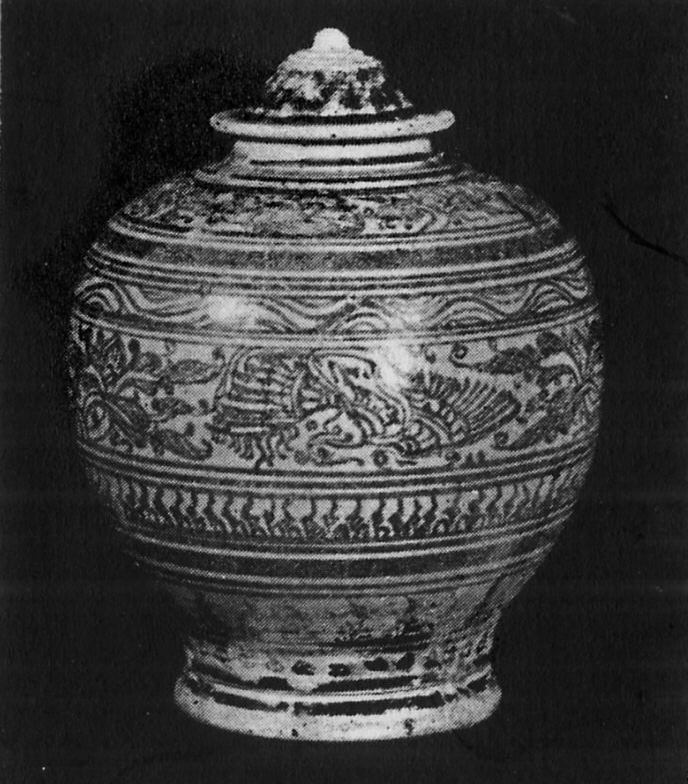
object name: covered jar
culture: thai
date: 1401-1600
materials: earthenware, glaze, iron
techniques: underglaze